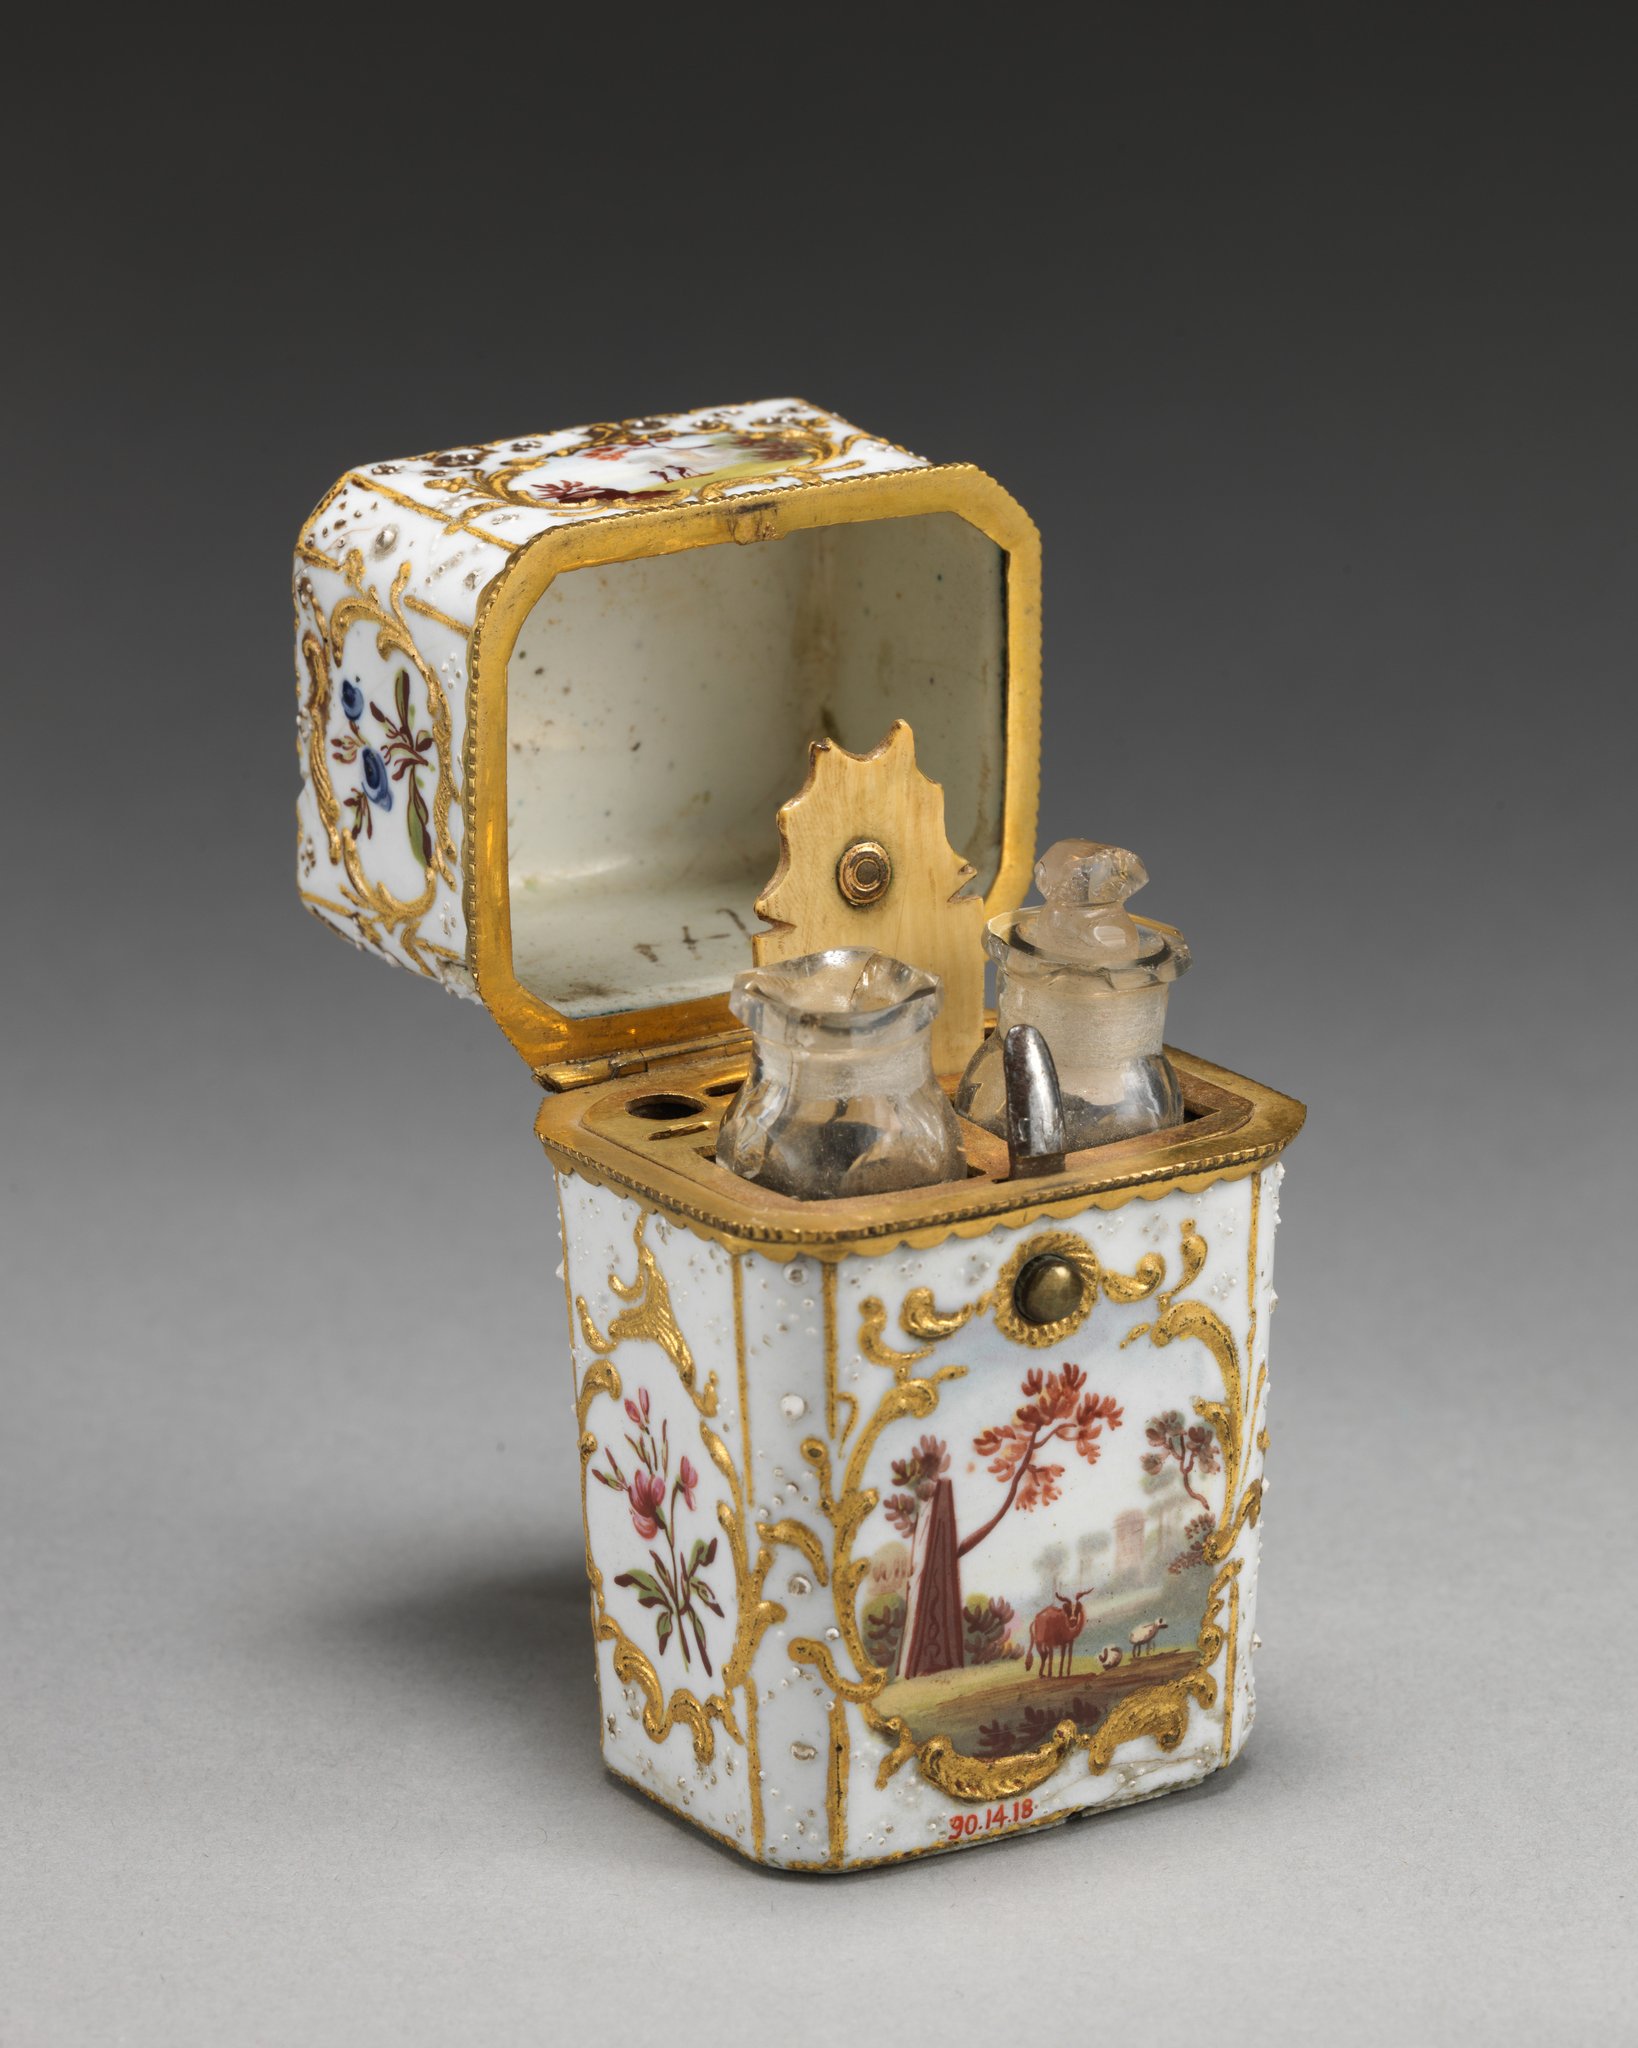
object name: nécessaire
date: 1765-1770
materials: copper, enamel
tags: animals